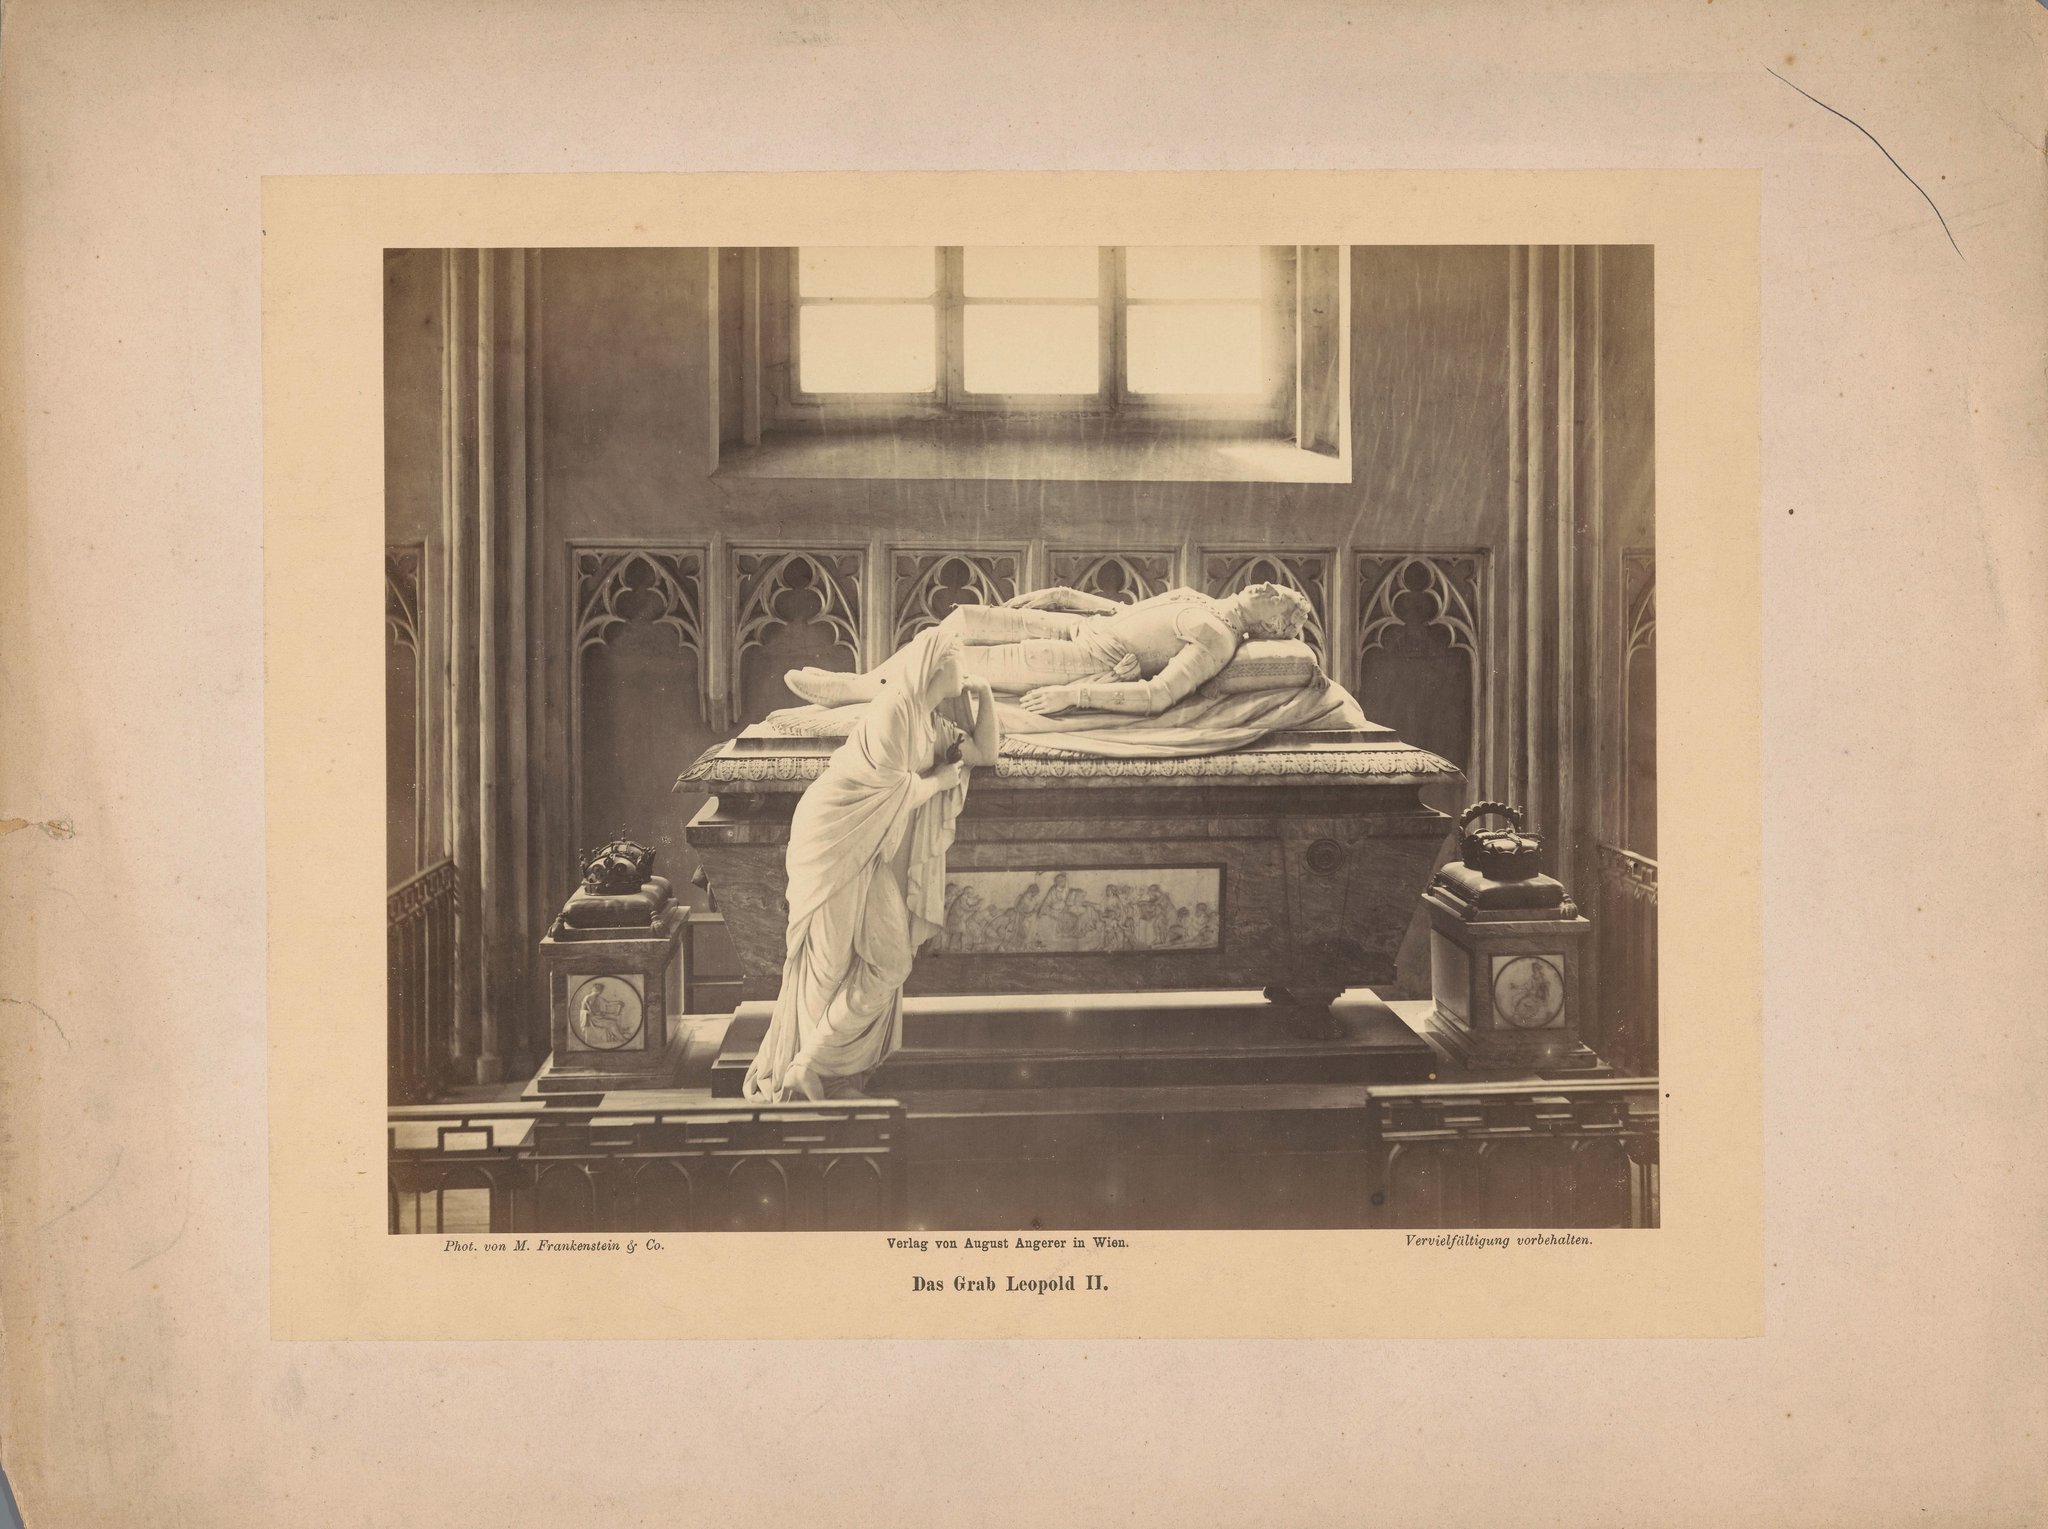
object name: photograph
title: Het graf van Keizer Leopold II in de Kapucijner Grafkelder te Wenen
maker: august angerer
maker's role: publisher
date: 1850-1900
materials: cardboard, photographic support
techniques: albumen print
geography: vienna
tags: leopold ii (keizer van oostenrijk), grave, tomb, vienna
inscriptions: inscription: ‘Vervielfültigung vorbehalten.’, collector's mark: Lugt 3937